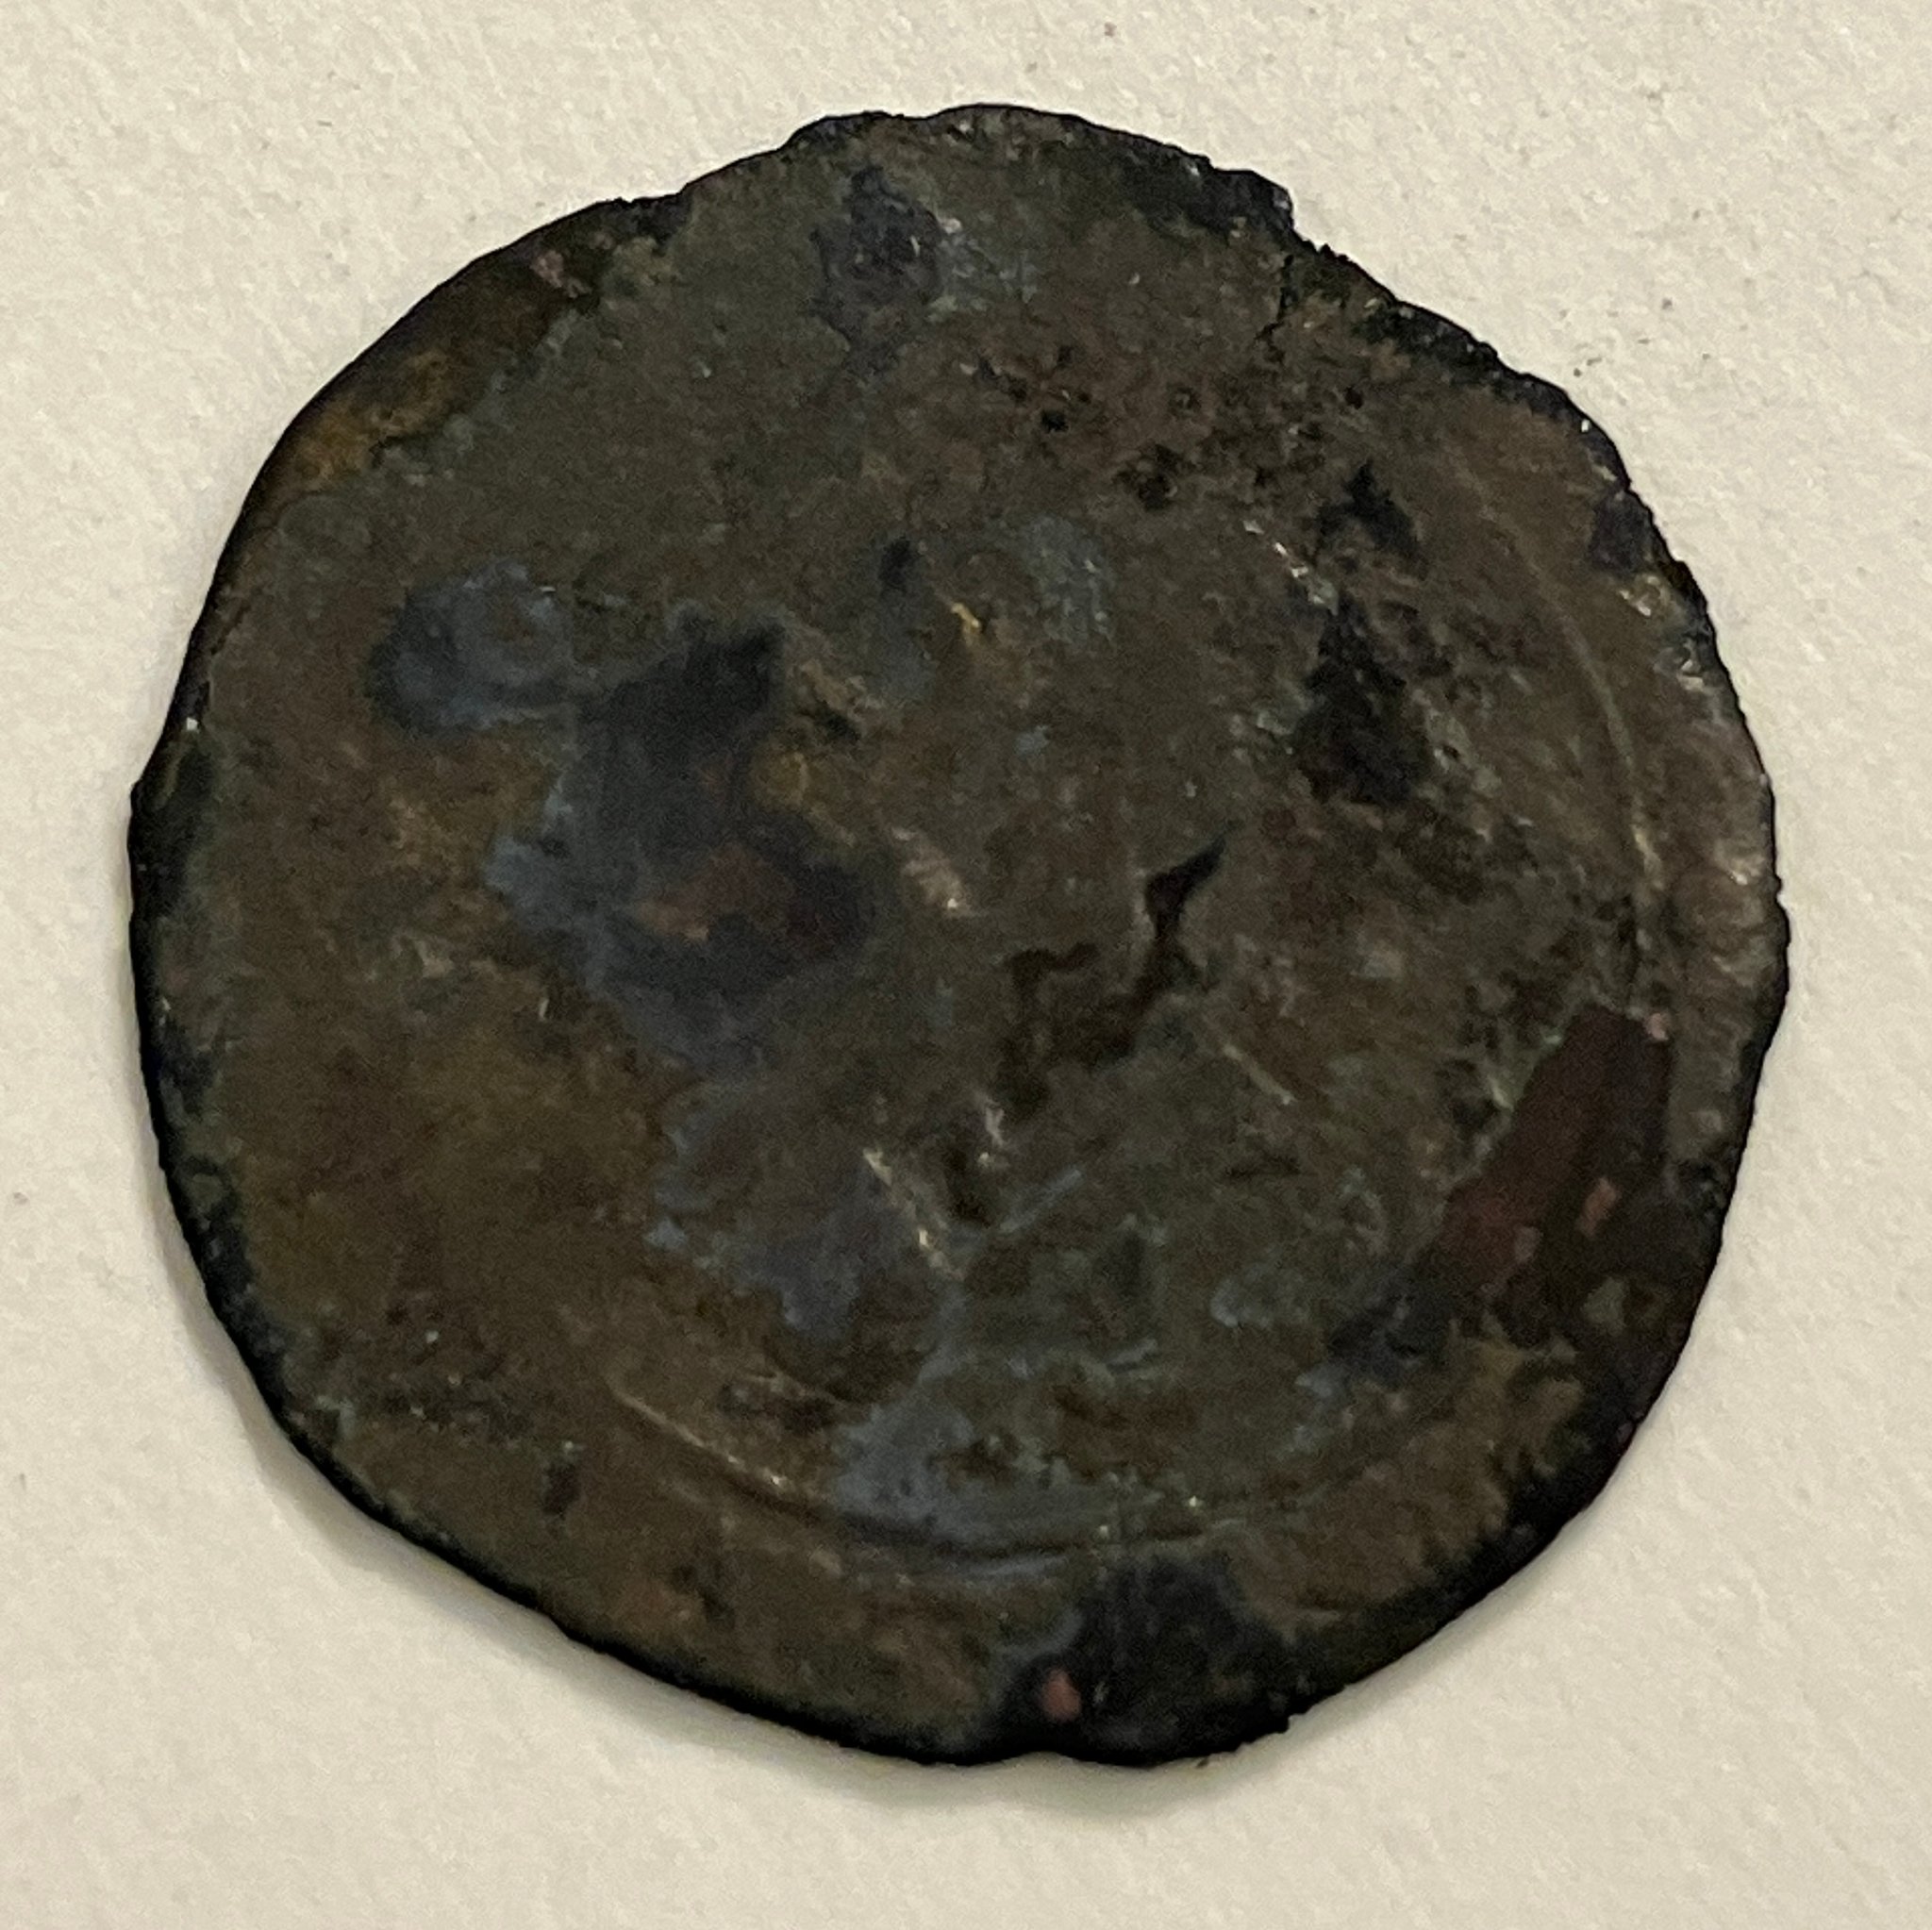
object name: coin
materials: silver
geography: uzbekistan